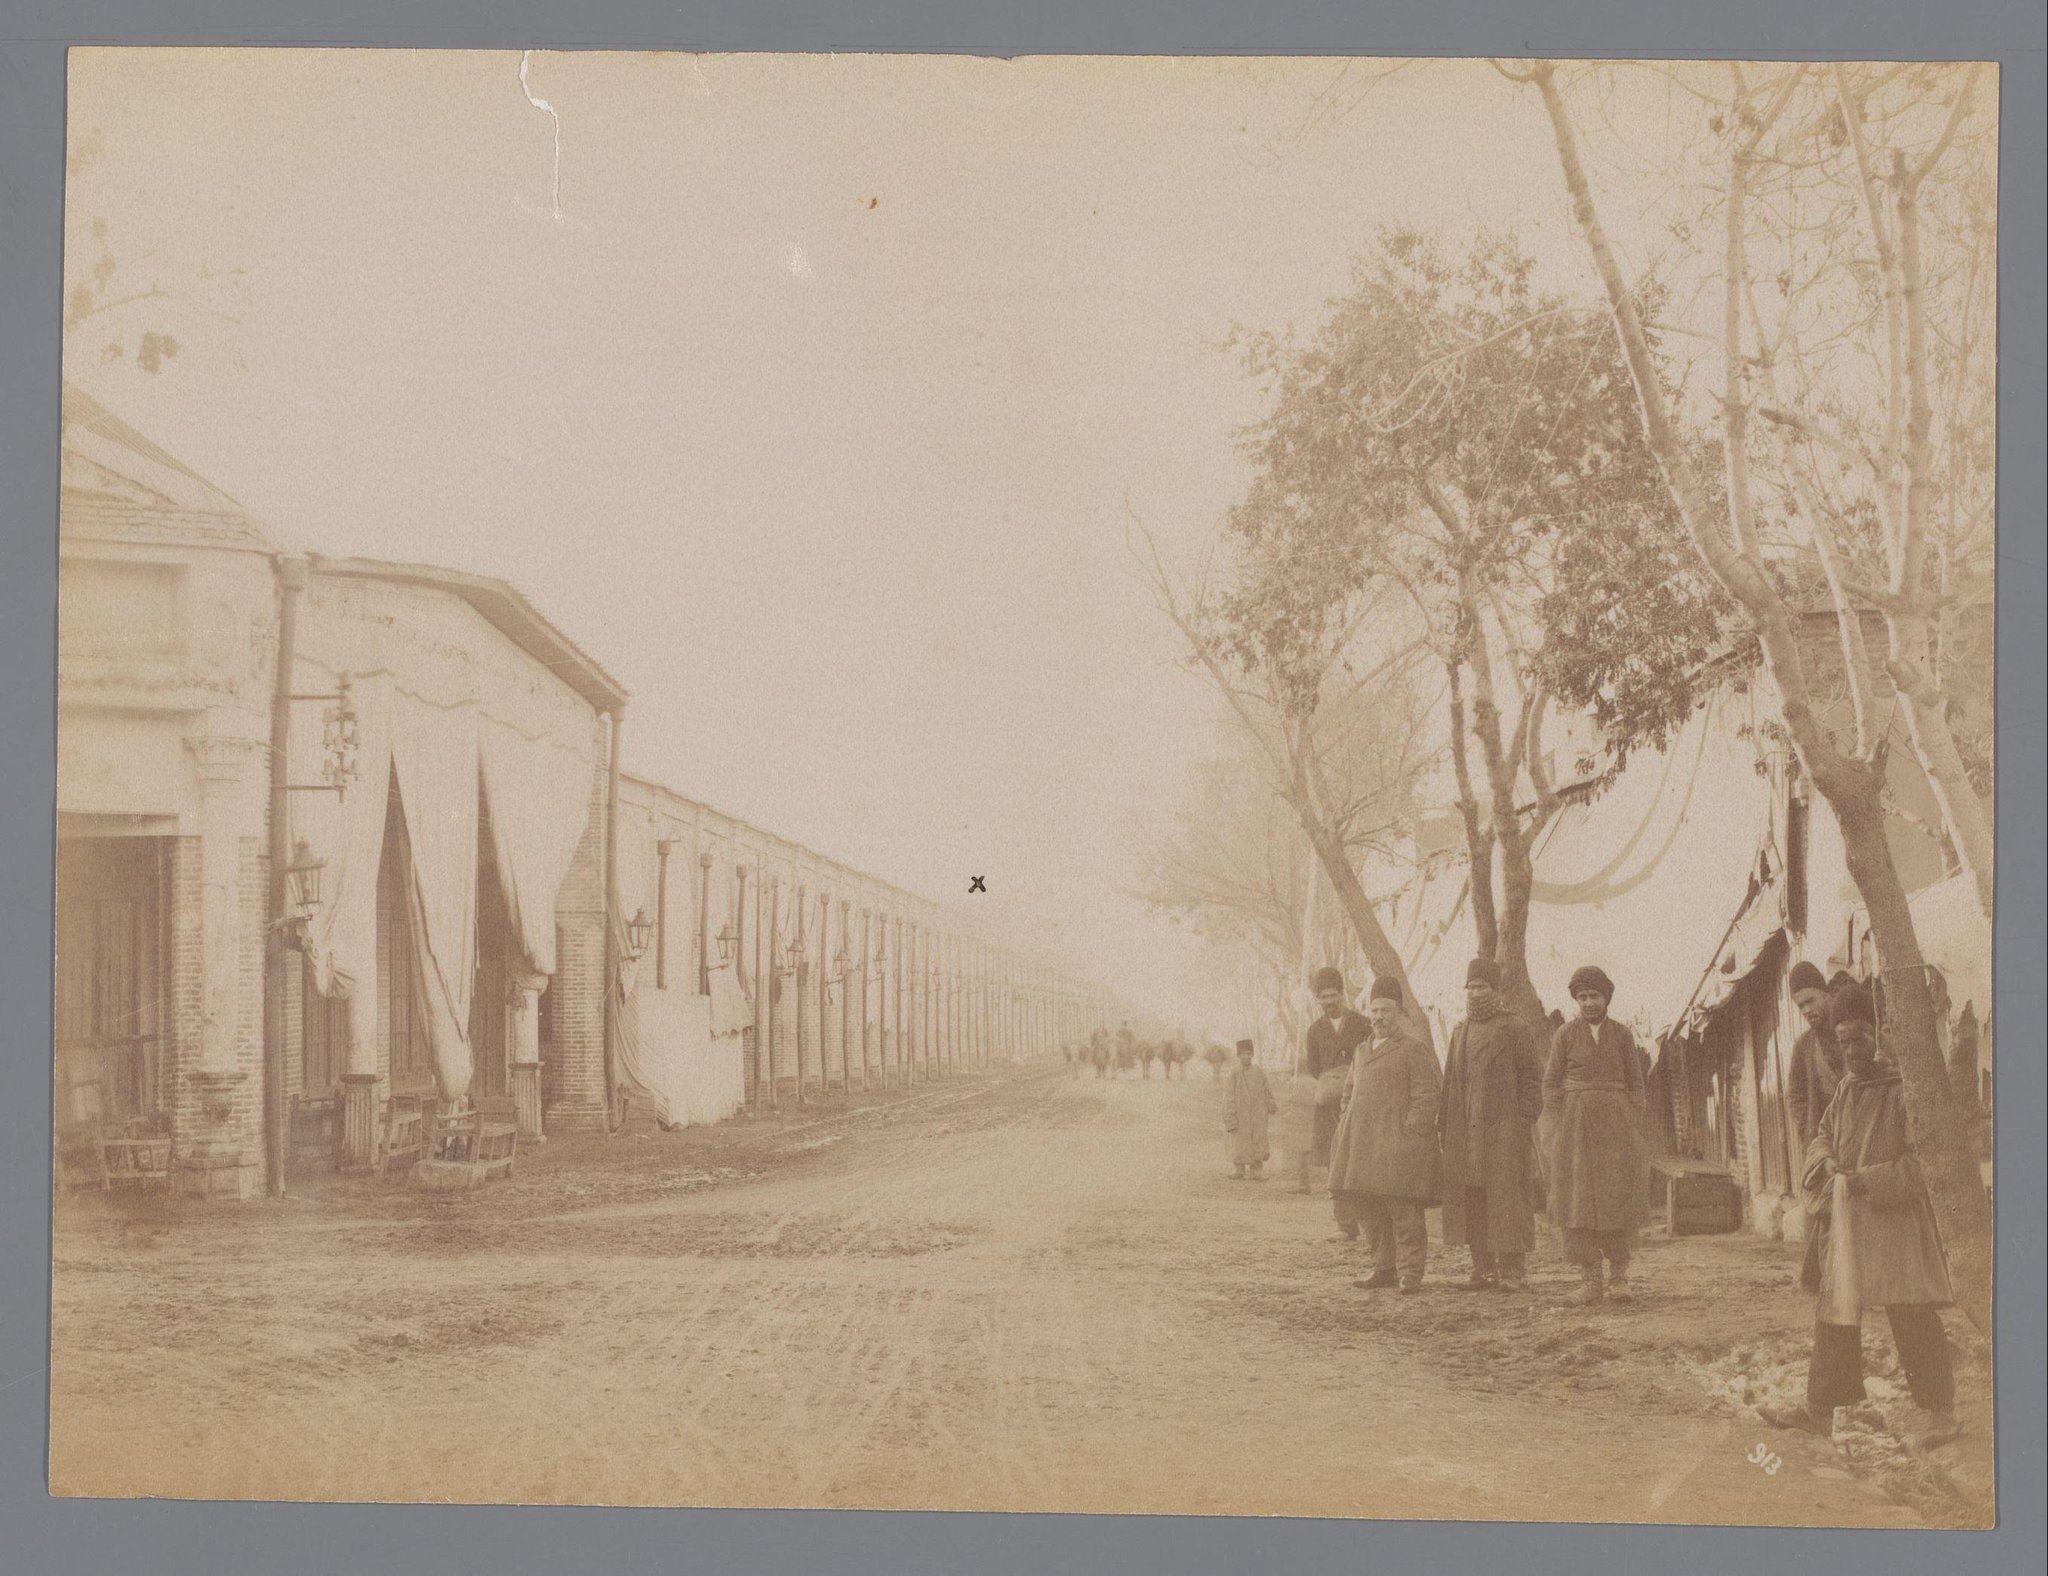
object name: photograph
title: Avenue Lalezan, Teheran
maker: antoine sevruguin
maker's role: fotograaf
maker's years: 1840-1933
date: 1885-1910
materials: paper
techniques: albumen print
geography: iran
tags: teheran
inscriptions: number: ‘18.’, number: ‘913’, inscription: ‘Teheran//Avenue Lalezan’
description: Avenue Lalezan, Teheran, Iran. Een rij lichte, lage behuizing aan de linker zijde, rechts van de straat een aantal mannen in warme winterkleding die in de camera kijken.